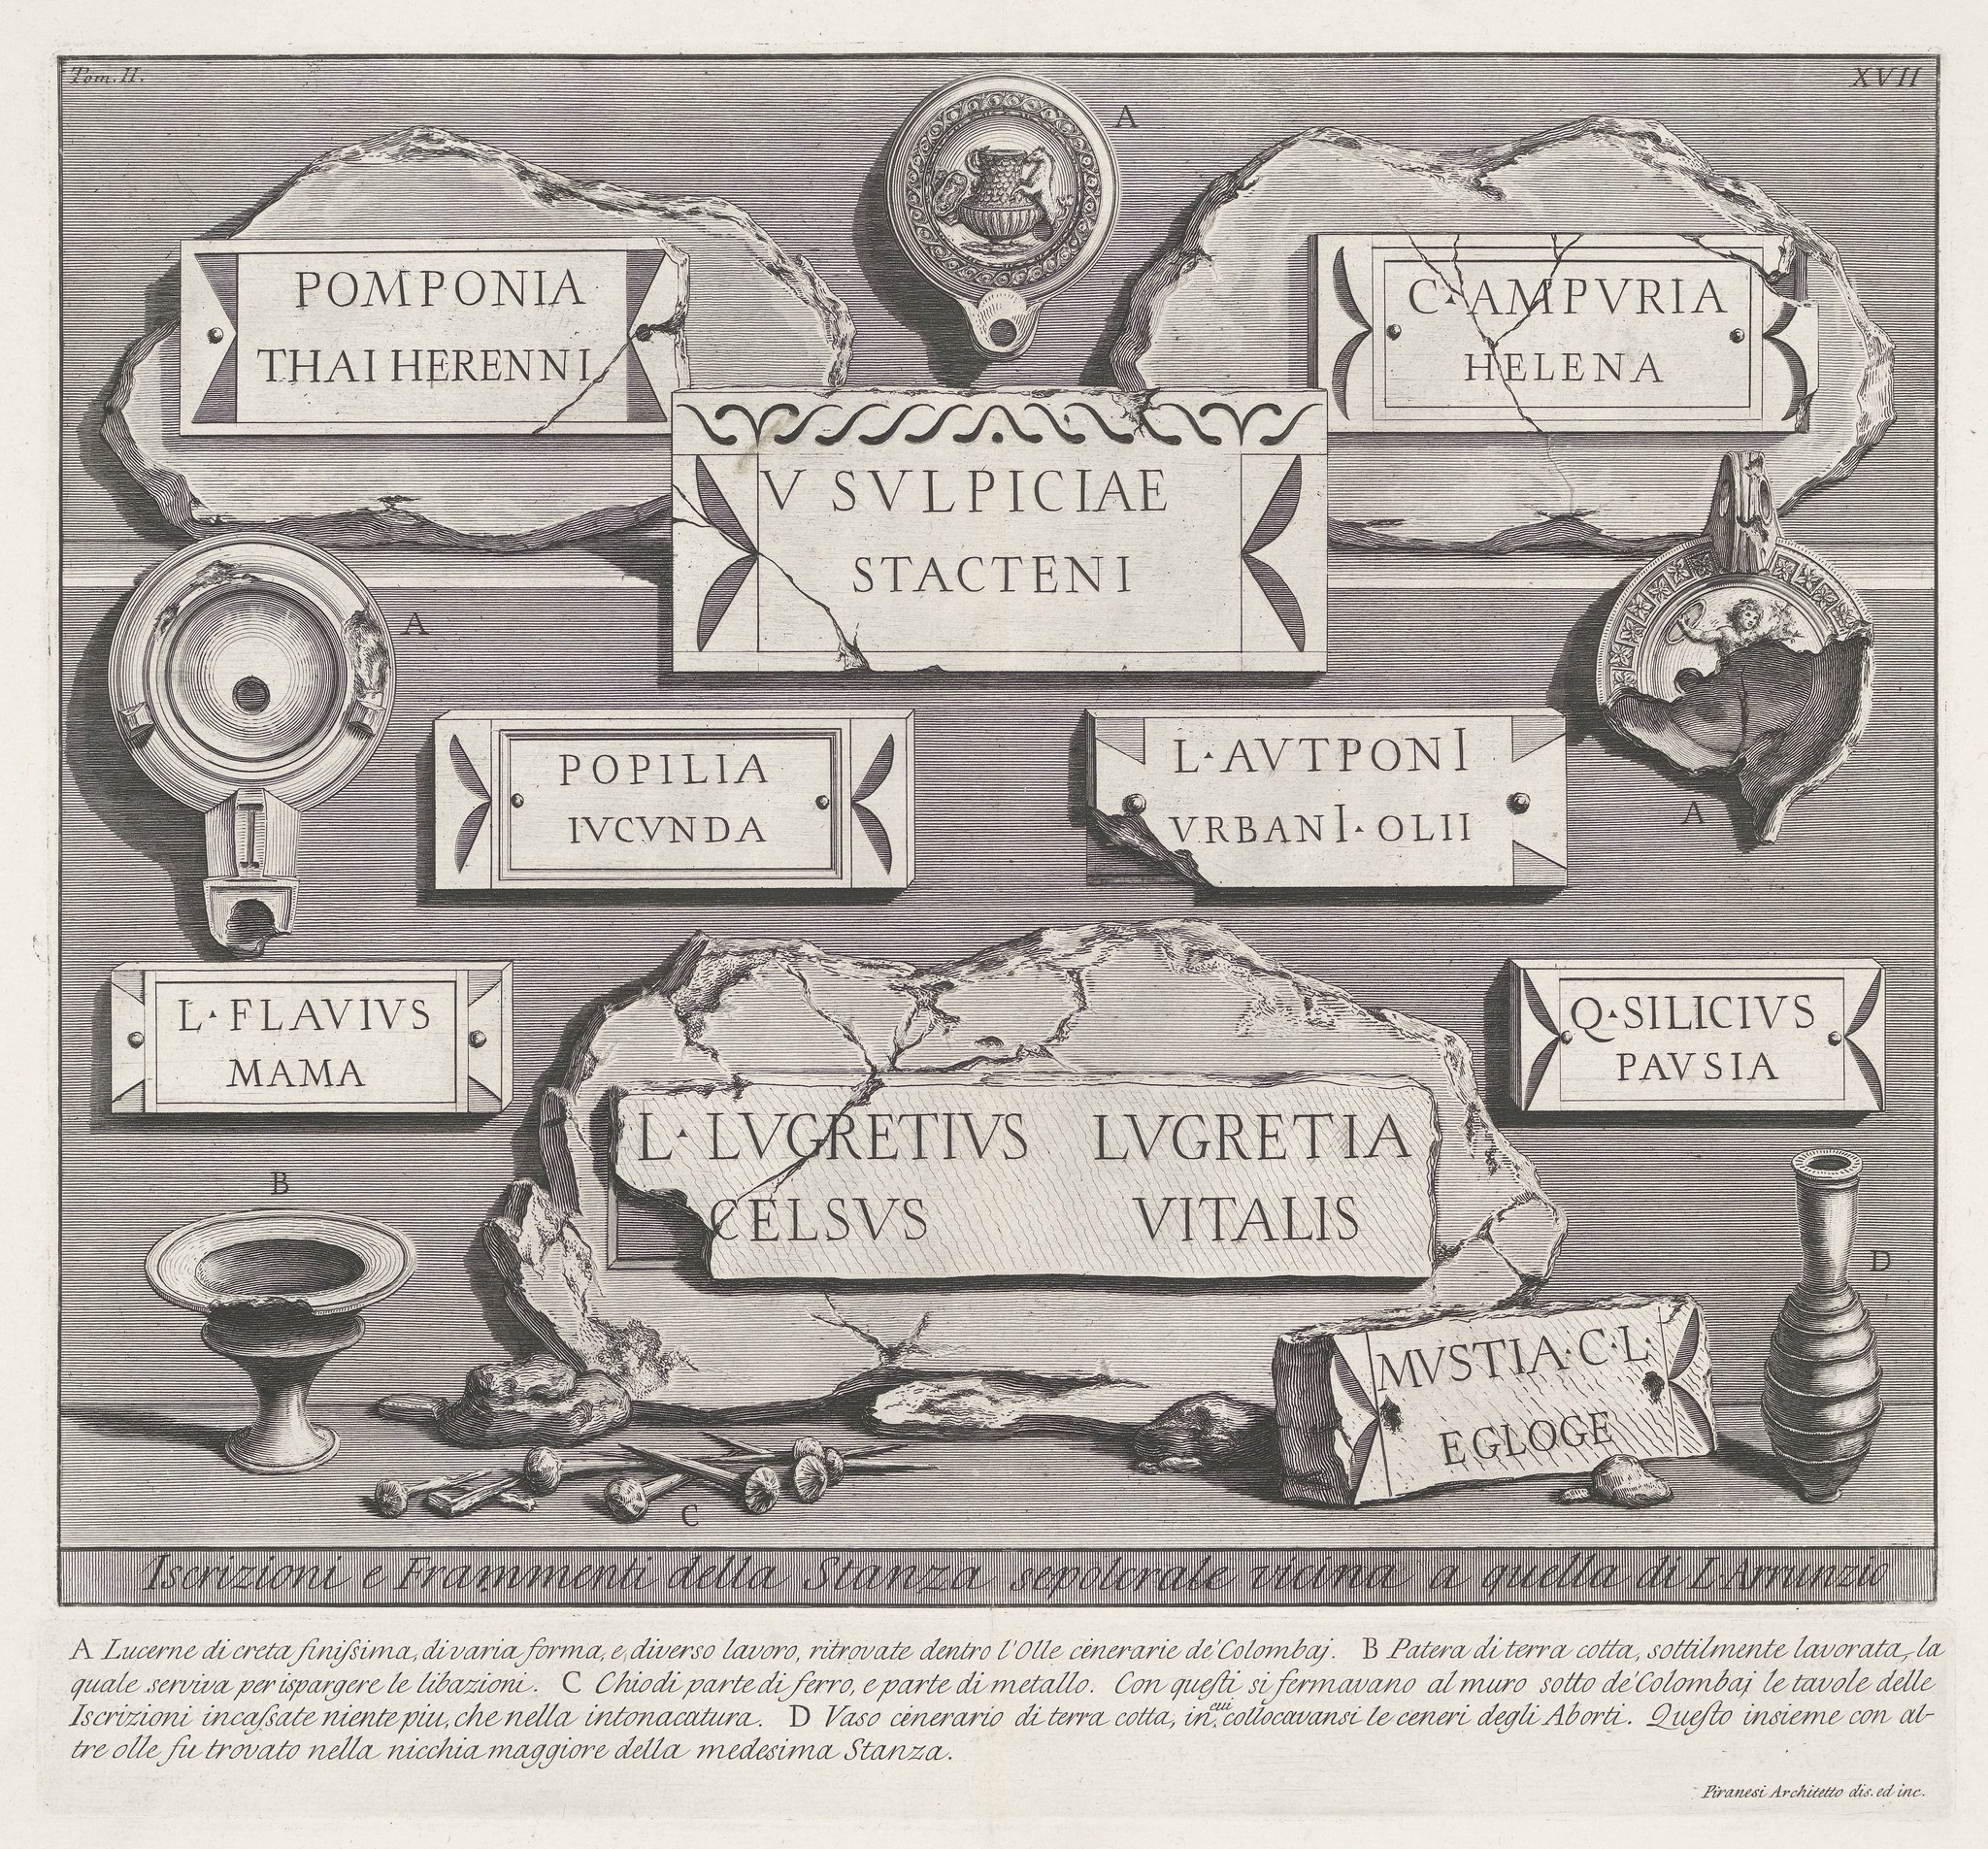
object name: print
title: Iscrizioni en Frammenti della Stanza sepolcrale vicina a qualla di L. Arrunzio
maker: giovanni battista piranesi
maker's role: designer, draughtsman, print maker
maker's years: 1720-1778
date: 1756-1757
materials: paper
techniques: etching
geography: rome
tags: inscription, vase ~ ornament, oil-lamp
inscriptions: collector's mark: Lugt 2228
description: Deze prent maakt deel uit van de serie 'Le Antichità Romane'. Piranesi deed meer dan acht jaar voorstudie voor deze 250 platen tellende serie die in vier volumes werd uitgegeven. Hij produceerde de prenten tussen ca. 1756 en 1757. De serie bevat ook prenten door of naar andere prentmakers, onder wie Francesco Bianchini en Girolamo Rossi.